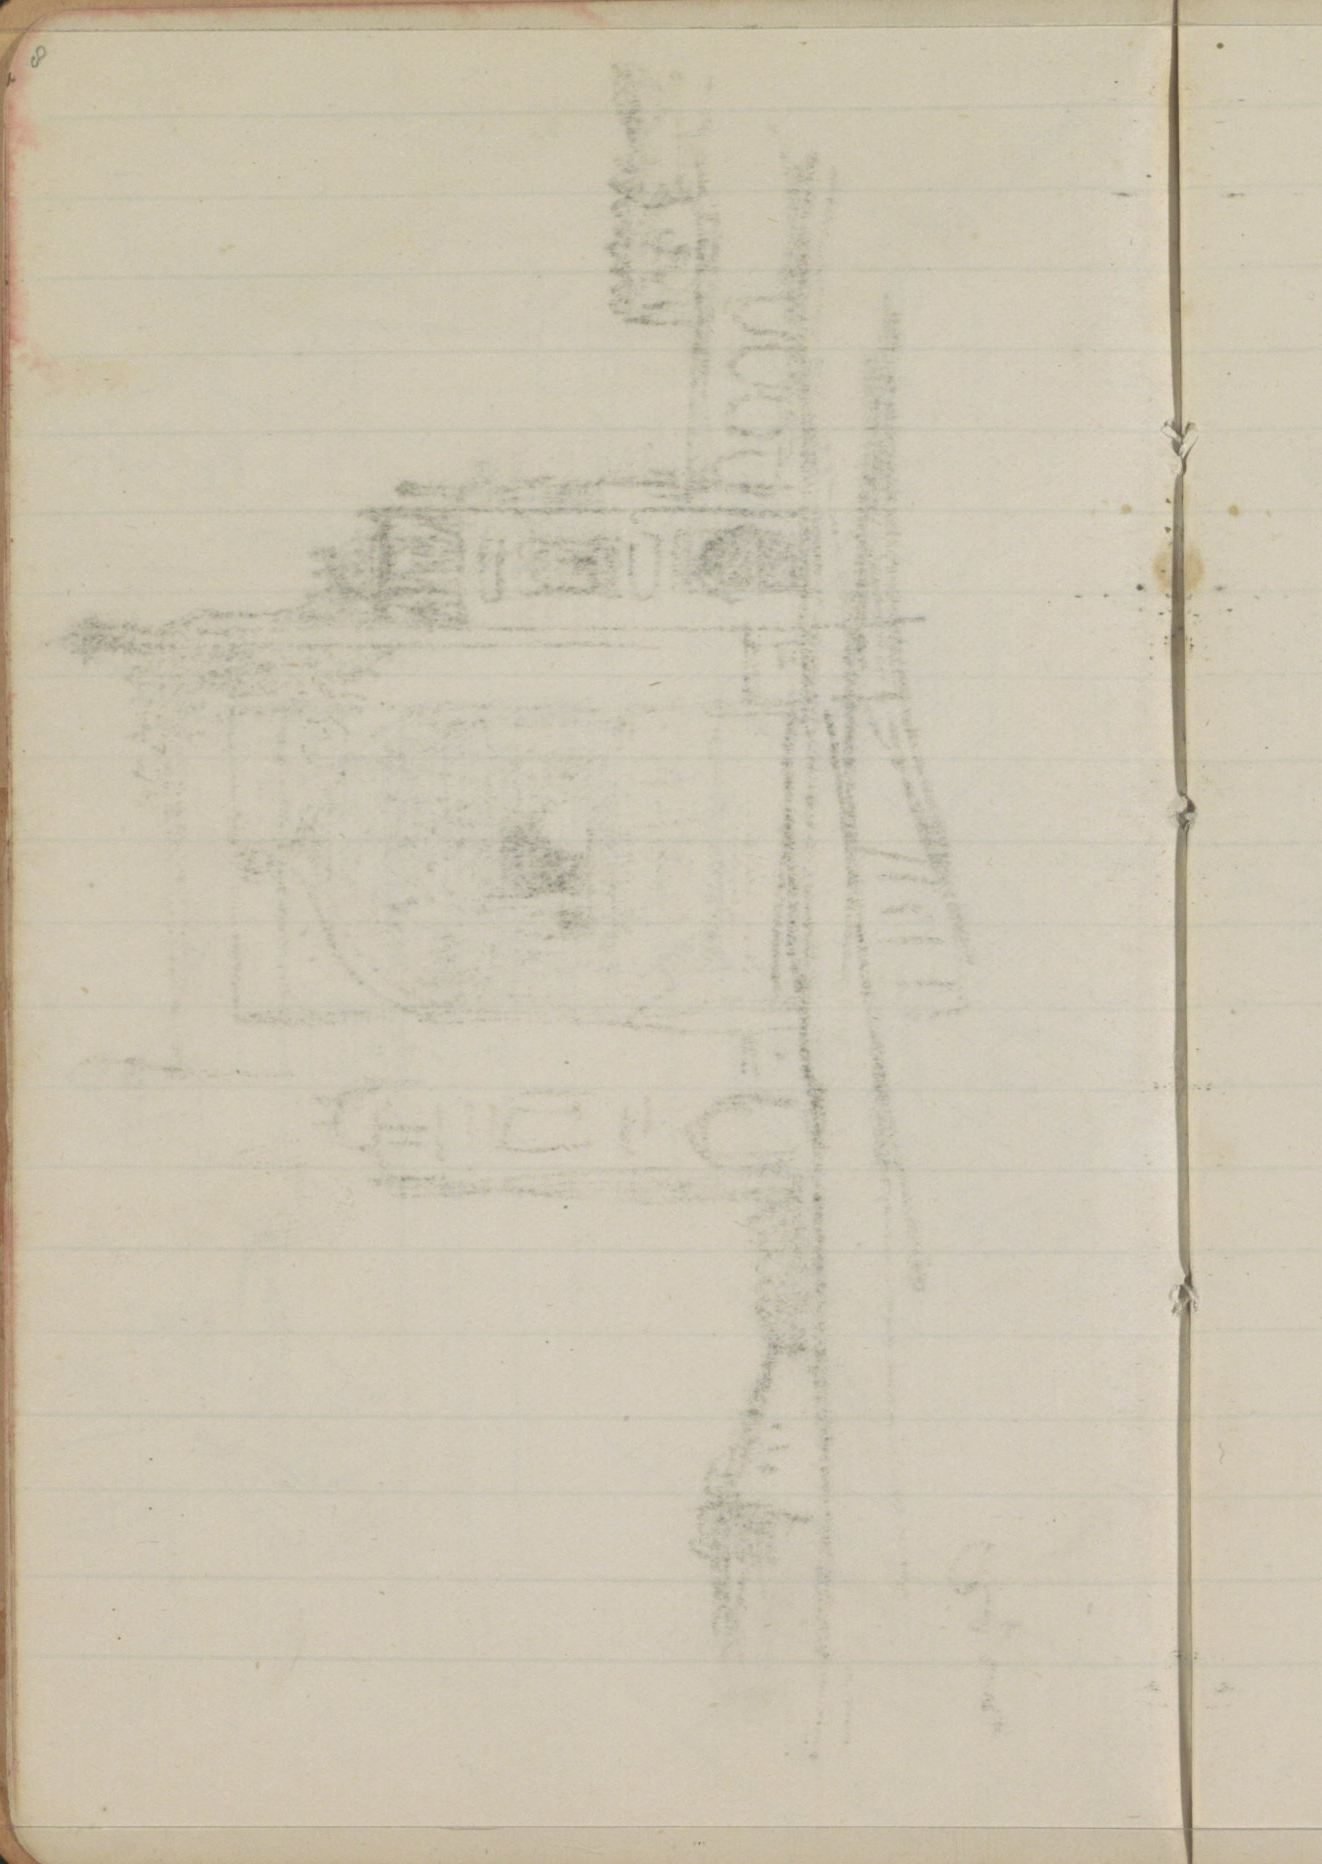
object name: sketchbook leaf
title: Abklatsch van de krijttekening op pagina 9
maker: marius bauer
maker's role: draughtsman, print maker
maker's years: 1867-1932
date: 1897-1898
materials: lined paper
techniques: printmaking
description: Pagina 8 uit een schetsboek met 36 bladen.